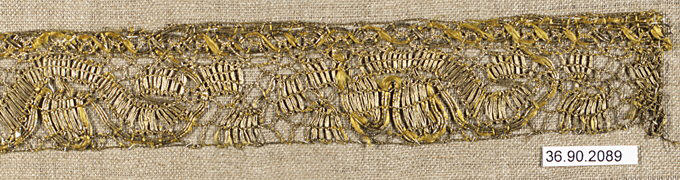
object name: piece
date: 1801-1900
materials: metal thread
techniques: lace